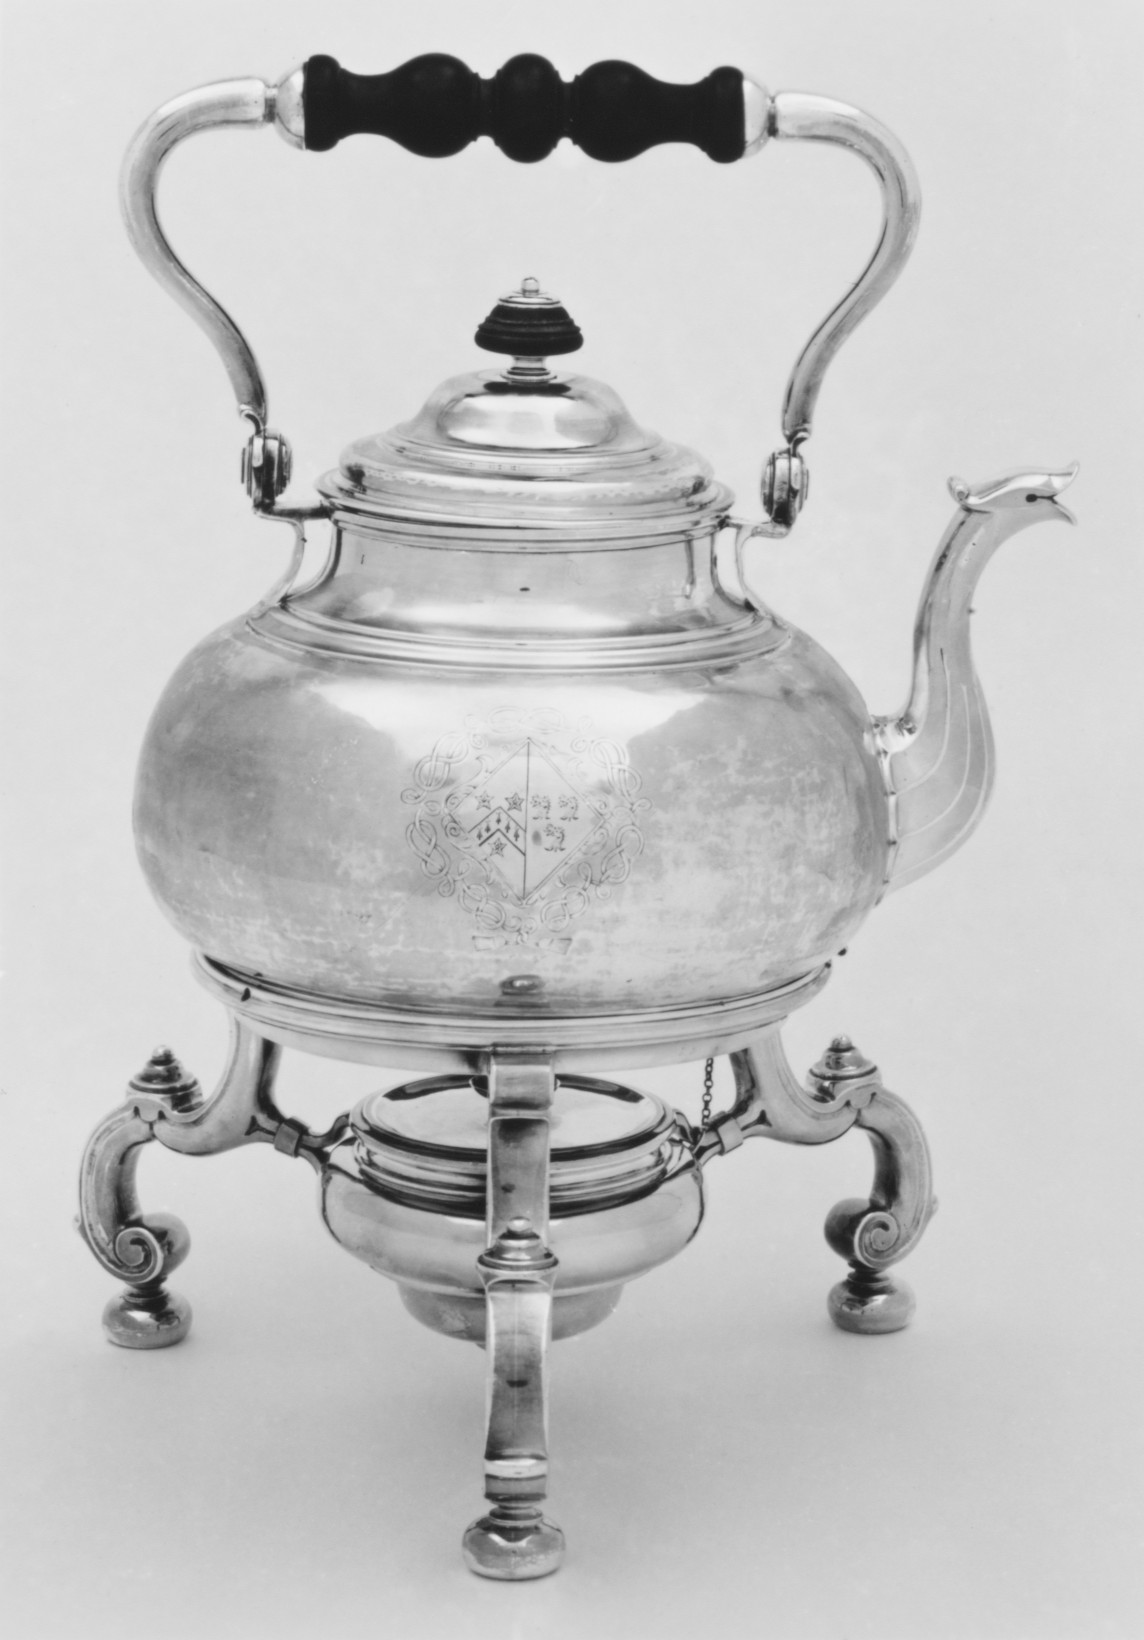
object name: kettle and lamp stand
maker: lewis mettayer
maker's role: maker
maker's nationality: british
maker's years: 1640-1740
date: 1708-1709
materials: silver, wood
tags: coat of arms